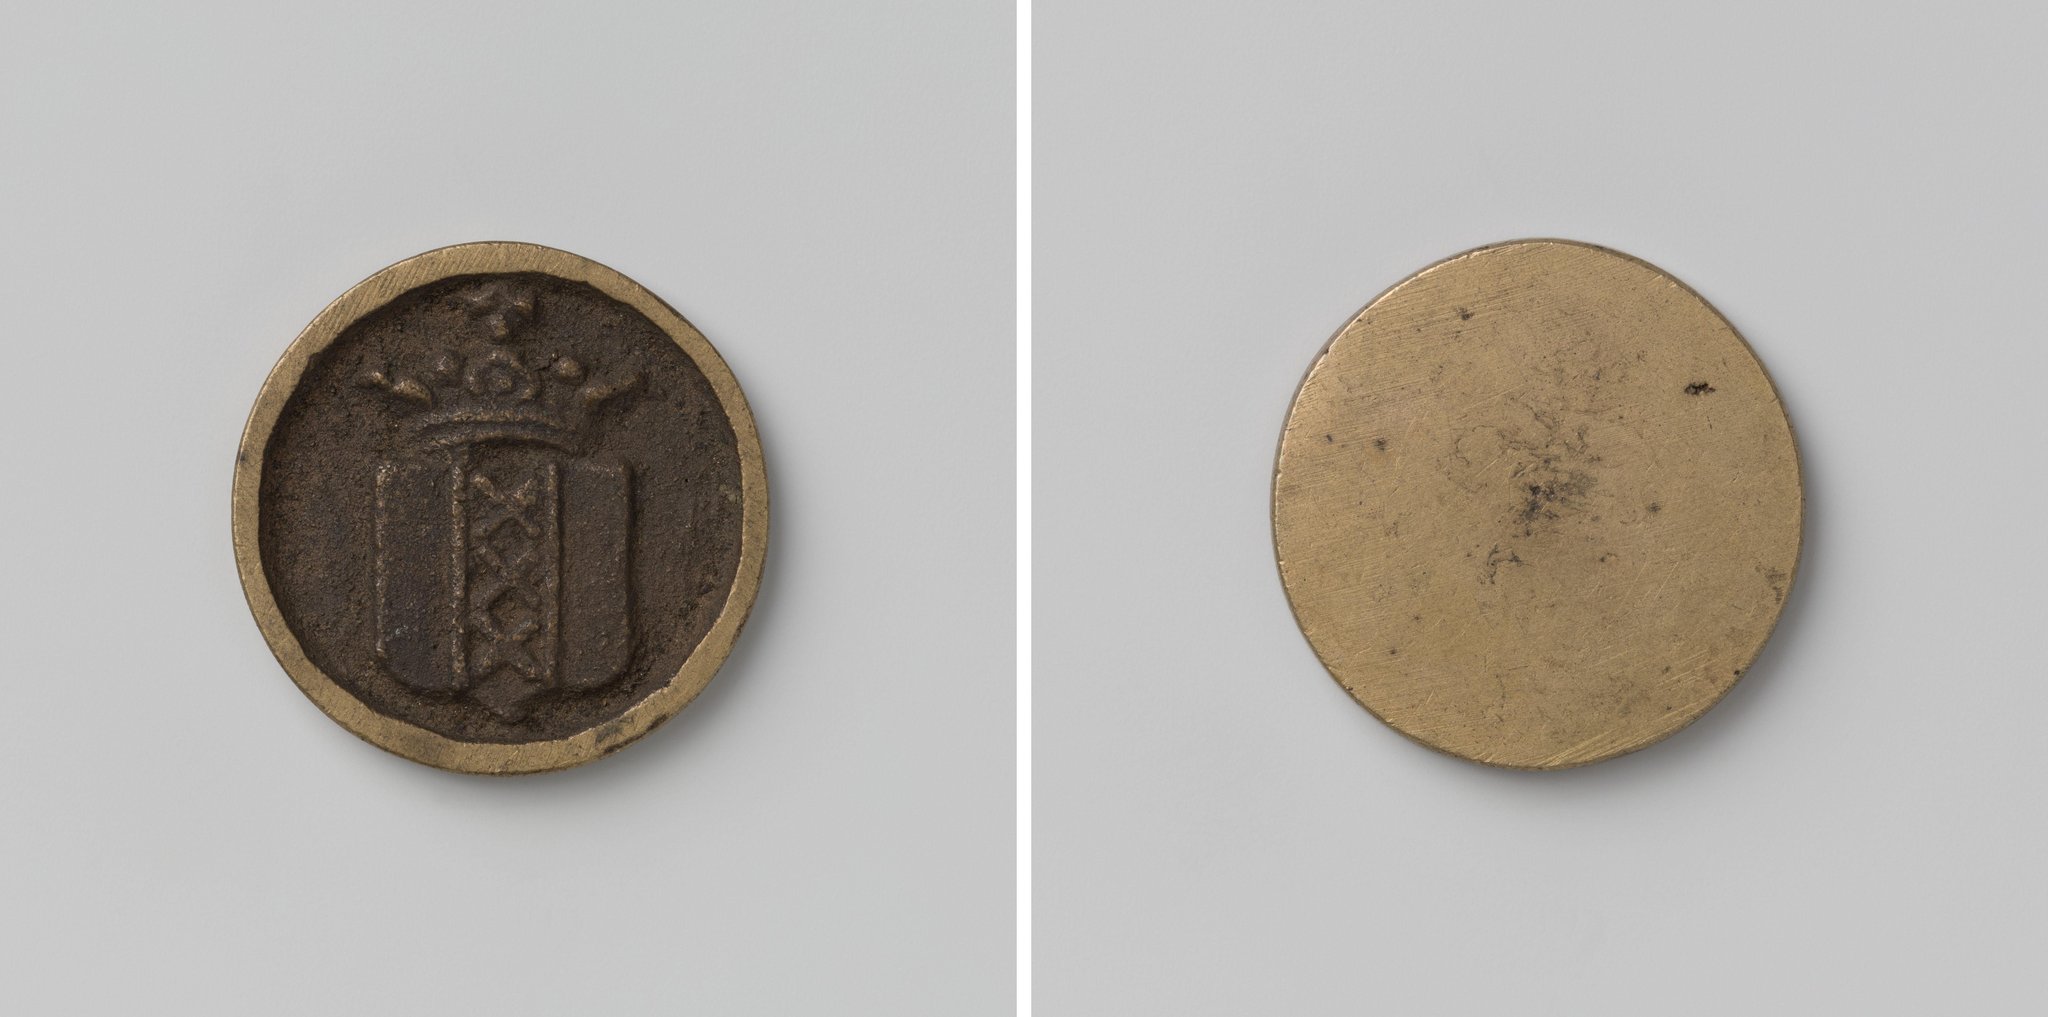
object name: medal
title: Amsterdam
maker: Anonymous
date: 1650-1750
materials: brass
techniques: casting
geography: amsterdam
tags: amsterdam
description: Eenzijdige messing penning. Voorzijde: gekroond wapenschild. Keerzijde: blanco